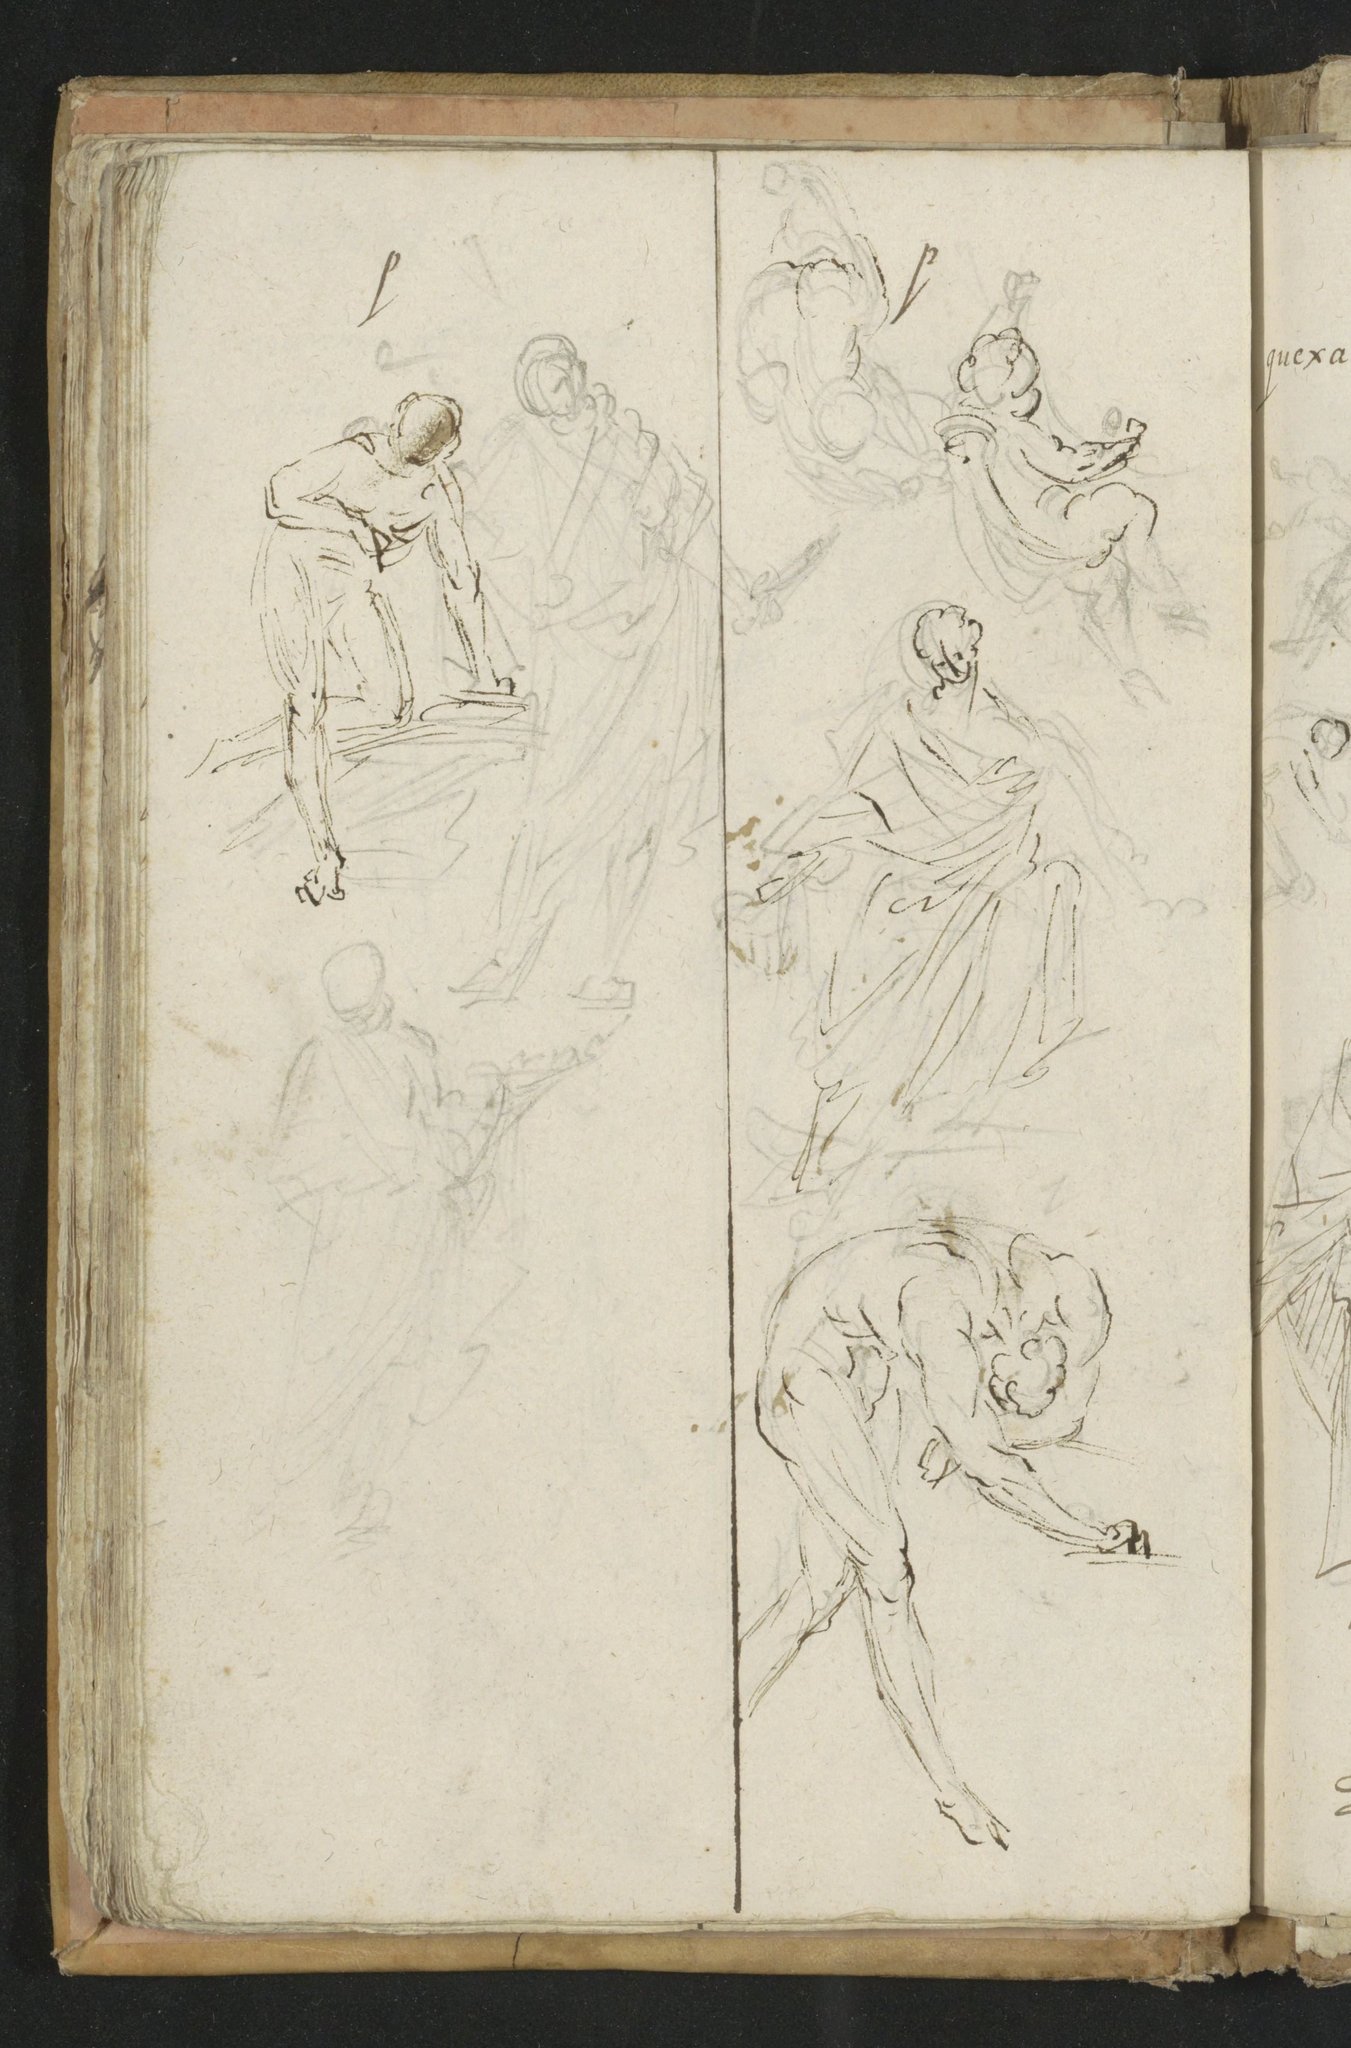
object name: sketchbook leaf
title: Putti, een vrouw in toga en mannen in verschillende buig- en stahoudingen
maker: Anonymous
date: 1658-1728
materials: ink, paper, pencil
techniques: pen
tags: standing figure, bending figure, cupids: 'amores', 'amoretti', 'putti'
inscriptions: annotation: ‘p p’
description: Blad 29 verso uit een schetsboek met 33 bladen.